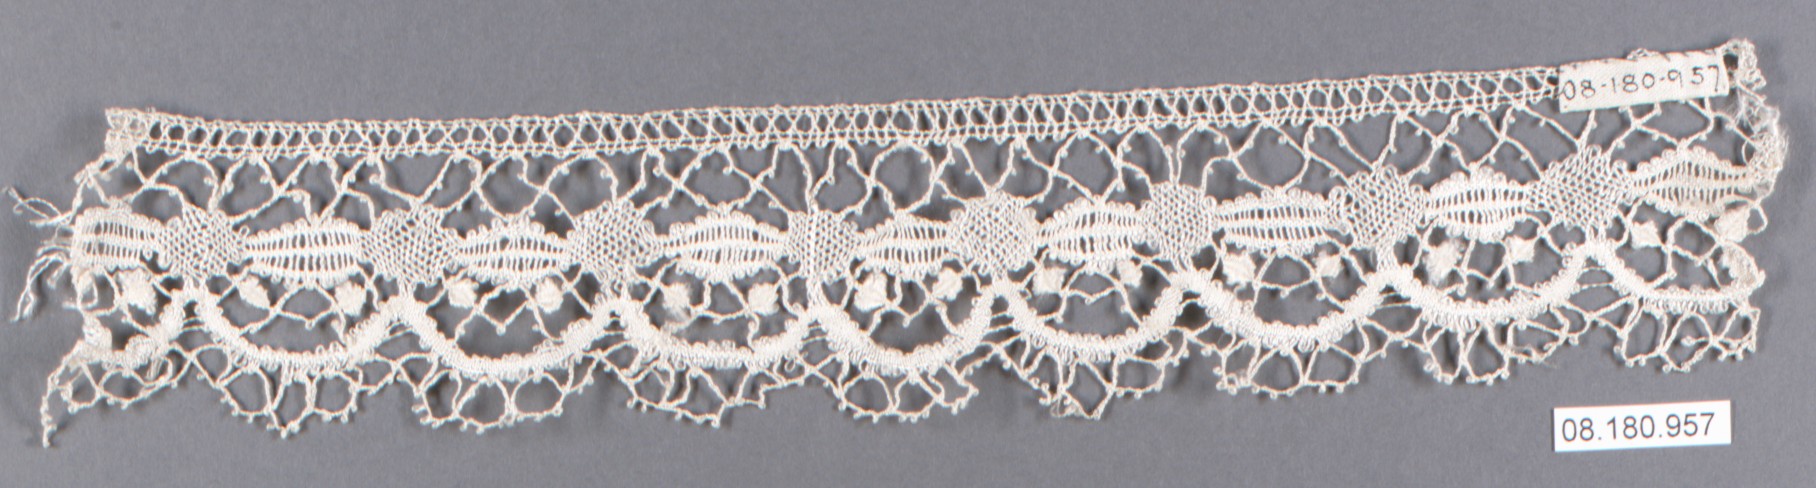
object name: fragment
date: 1801-1900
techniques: lace